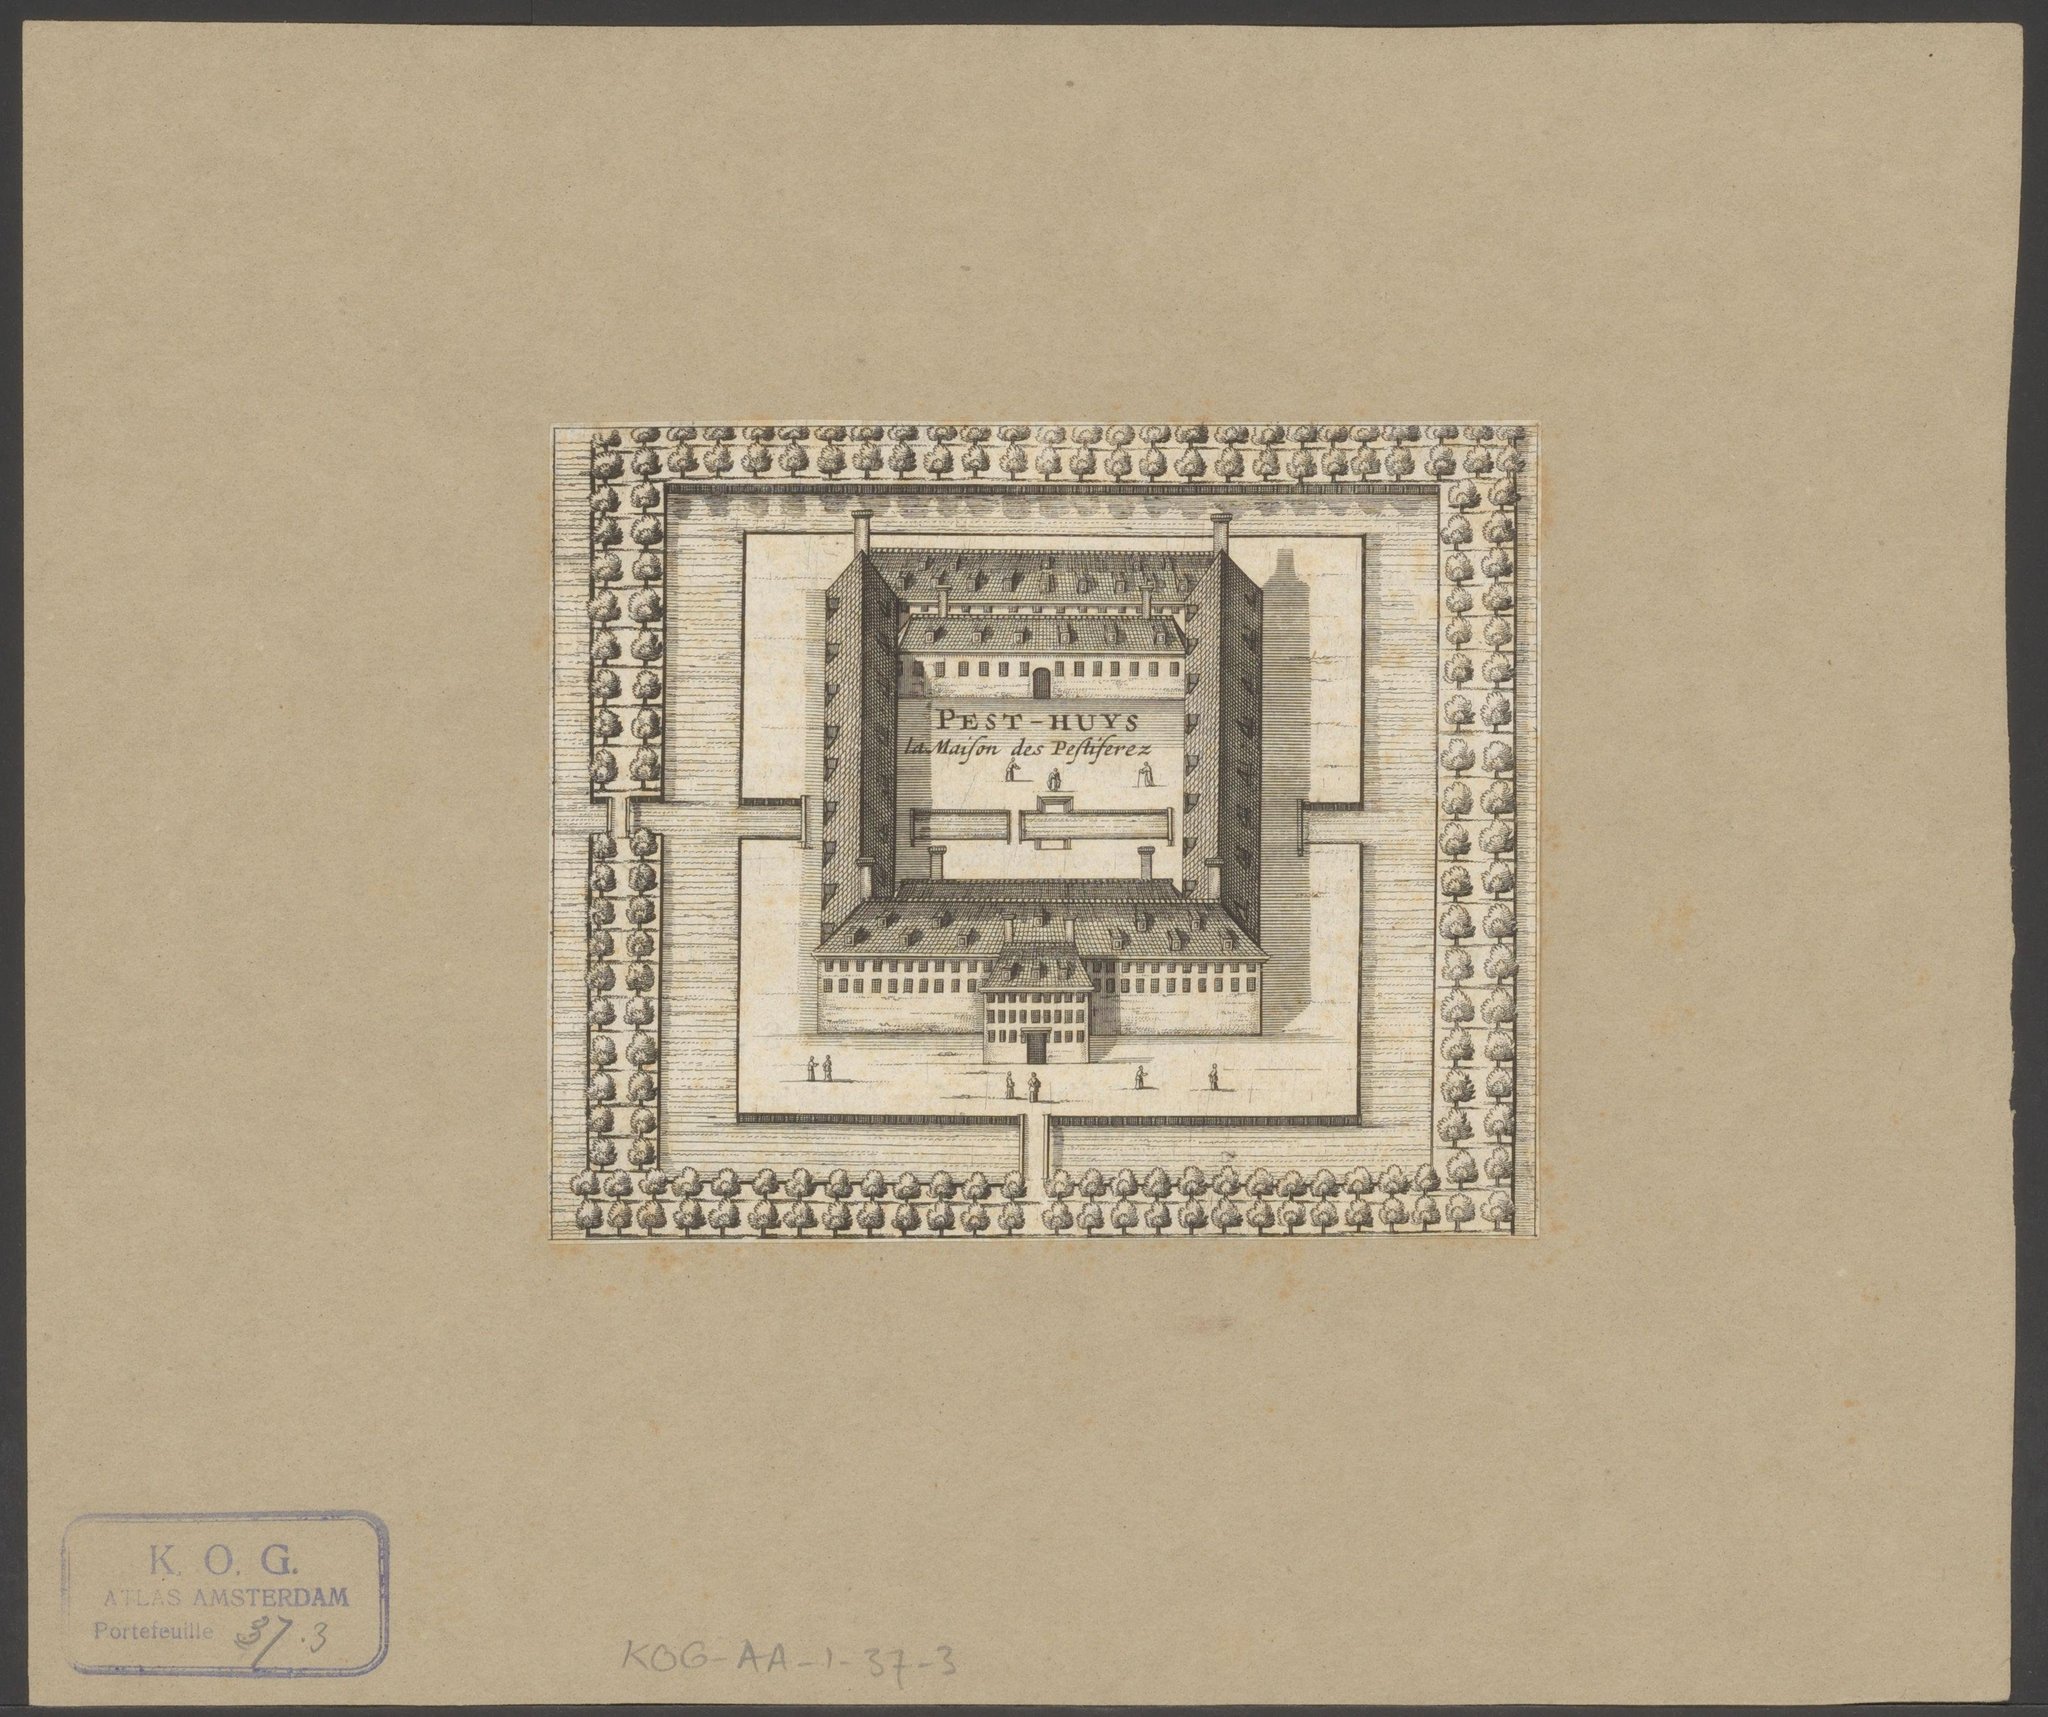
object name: book illustration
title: Gezicht in vogelvlucht op het Pesthuis (Buitengasthuis) bij Amsterdam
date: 1665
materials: paper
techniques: engraving, etching, letterpress printing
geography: amsterdam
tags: hospital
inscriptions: collector's mark: Lugt 1641b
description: Prent uit: Domselaer, Tobias en Isaac Commelin. Beschryvinge van Amsterdam (…). 6 dln. Amsterdam: Marcus Willemsz. Doornick, 1665, dl. 4, p. 122.